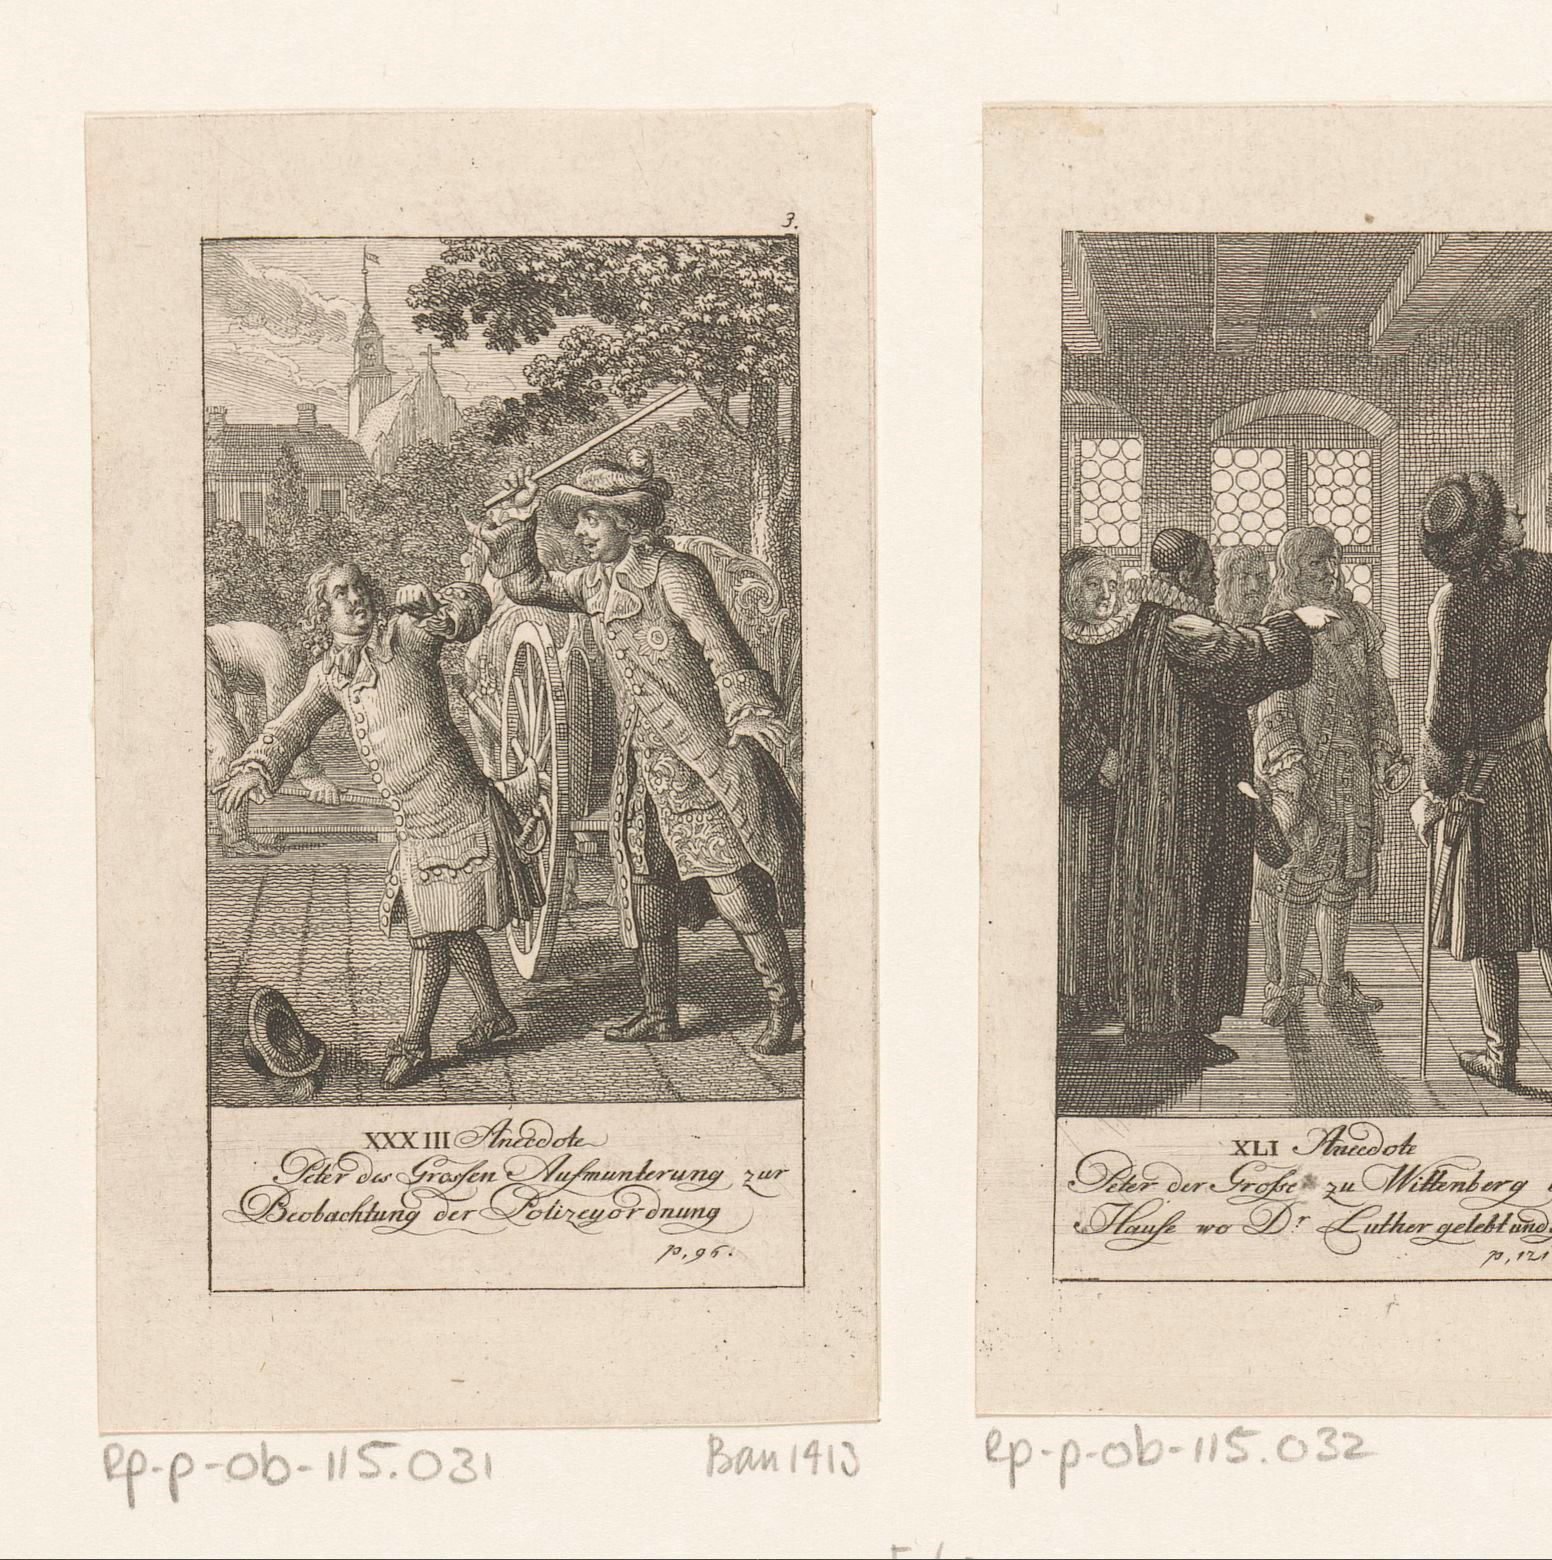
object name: book illustration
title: Peter de Grote wijst de sergeant op zijn onoplettendheid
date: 1789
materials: paper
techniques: etching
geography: gottingen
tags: peter i de grote (tsaar van rusland), history, hitting at something, emperor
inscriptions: collector's mark: Lugt 2228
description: Vervaardigd voor 'Anekdoten vom Peter dem Grossen'. Prent gebruikt voor: Goettinger Taschen Calender vom Jahr 1790. Göttingen: Johann Christoph Dietrich, [1789].